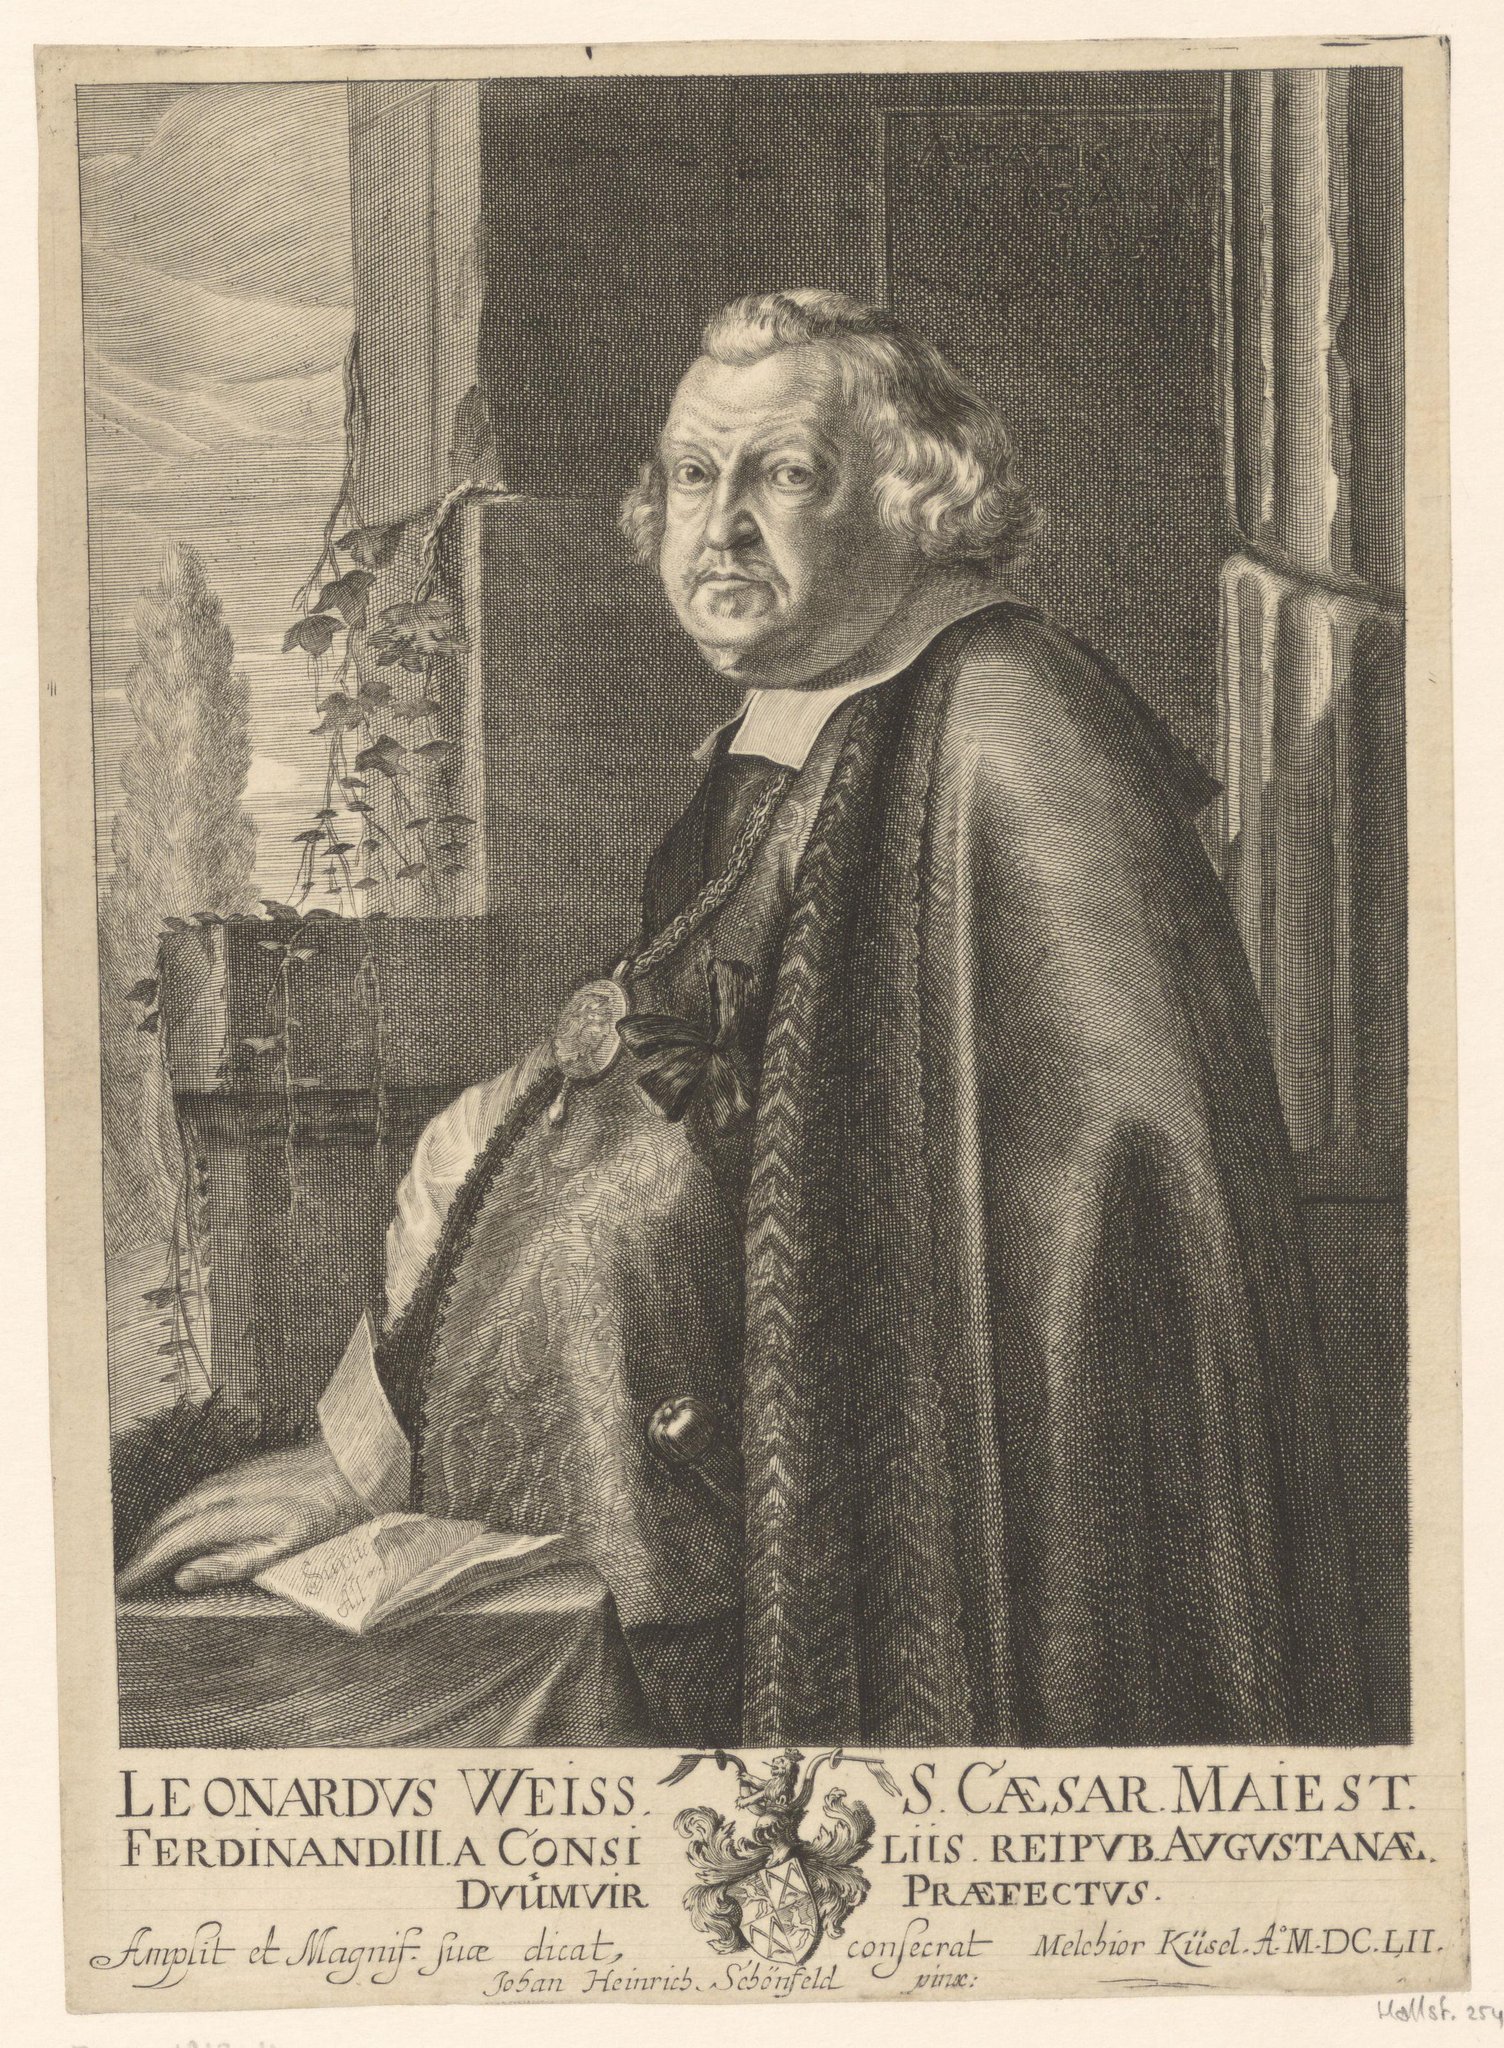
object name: print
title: Portret van Leonhard Weiss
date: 1652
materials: paper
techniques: engraving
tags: mayor, leonhard weiss (i), mayor, burgomaster, historical persons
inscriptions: collector's mark: Lugt 2228